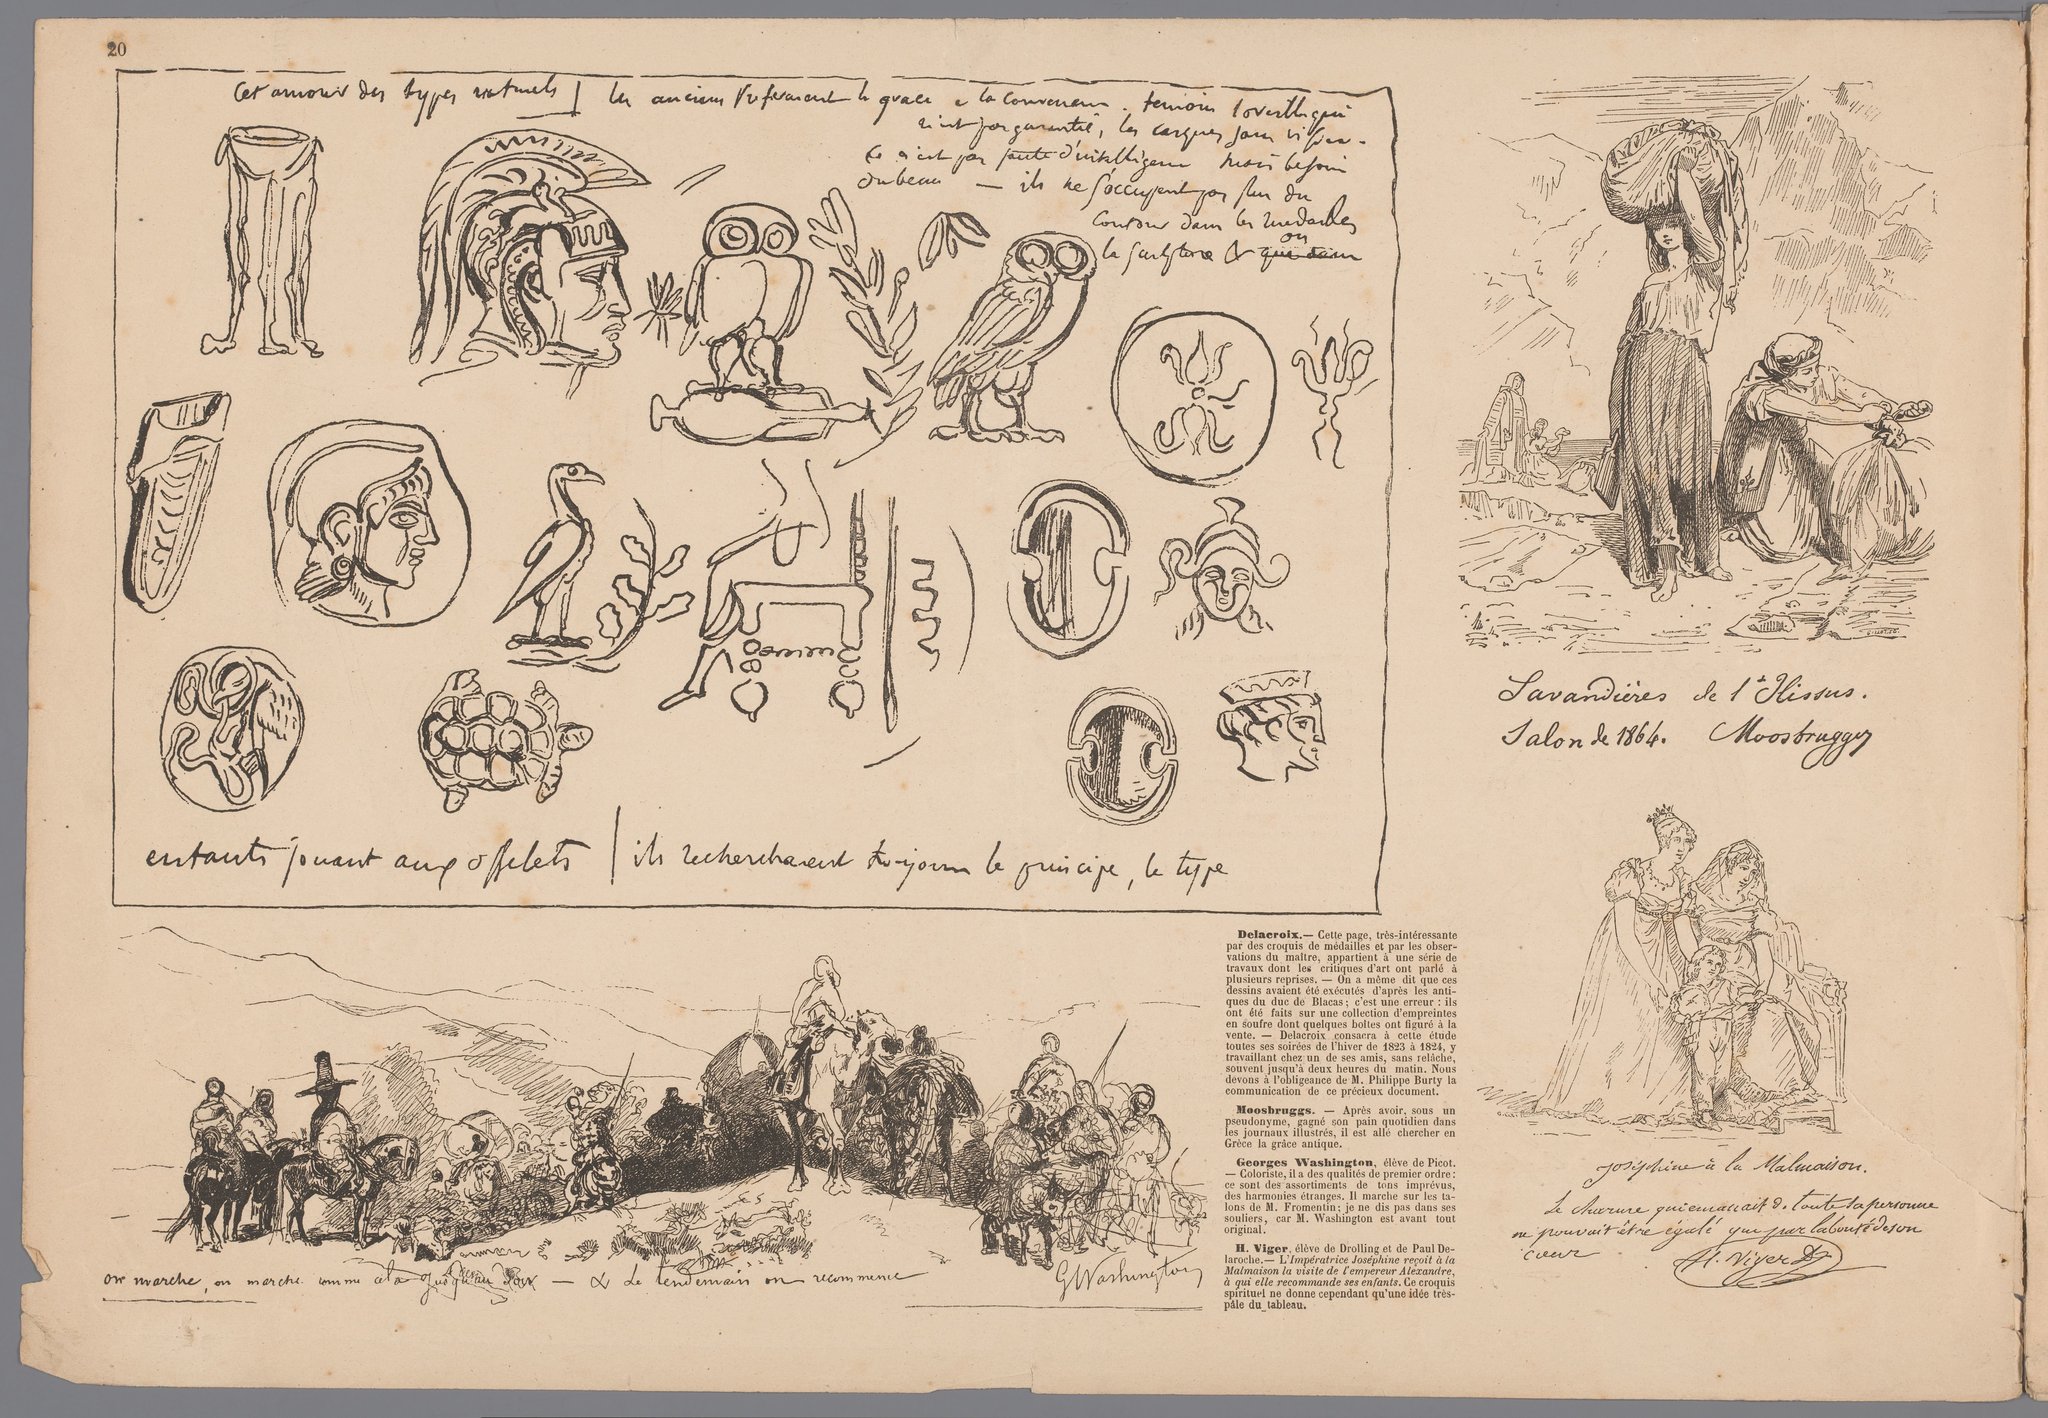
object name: print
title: Medailles en cameeën, wasvrouwen, reizend gezelschap te paard en twee vrouwen met kind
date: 1864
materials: paper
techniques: gillotage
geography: paris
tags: medal (considered as a piece of sculpture, regardless of its specific function), laundering, 'en route', traveller under way, mother and child(ren), woman and child(ren) (family group)